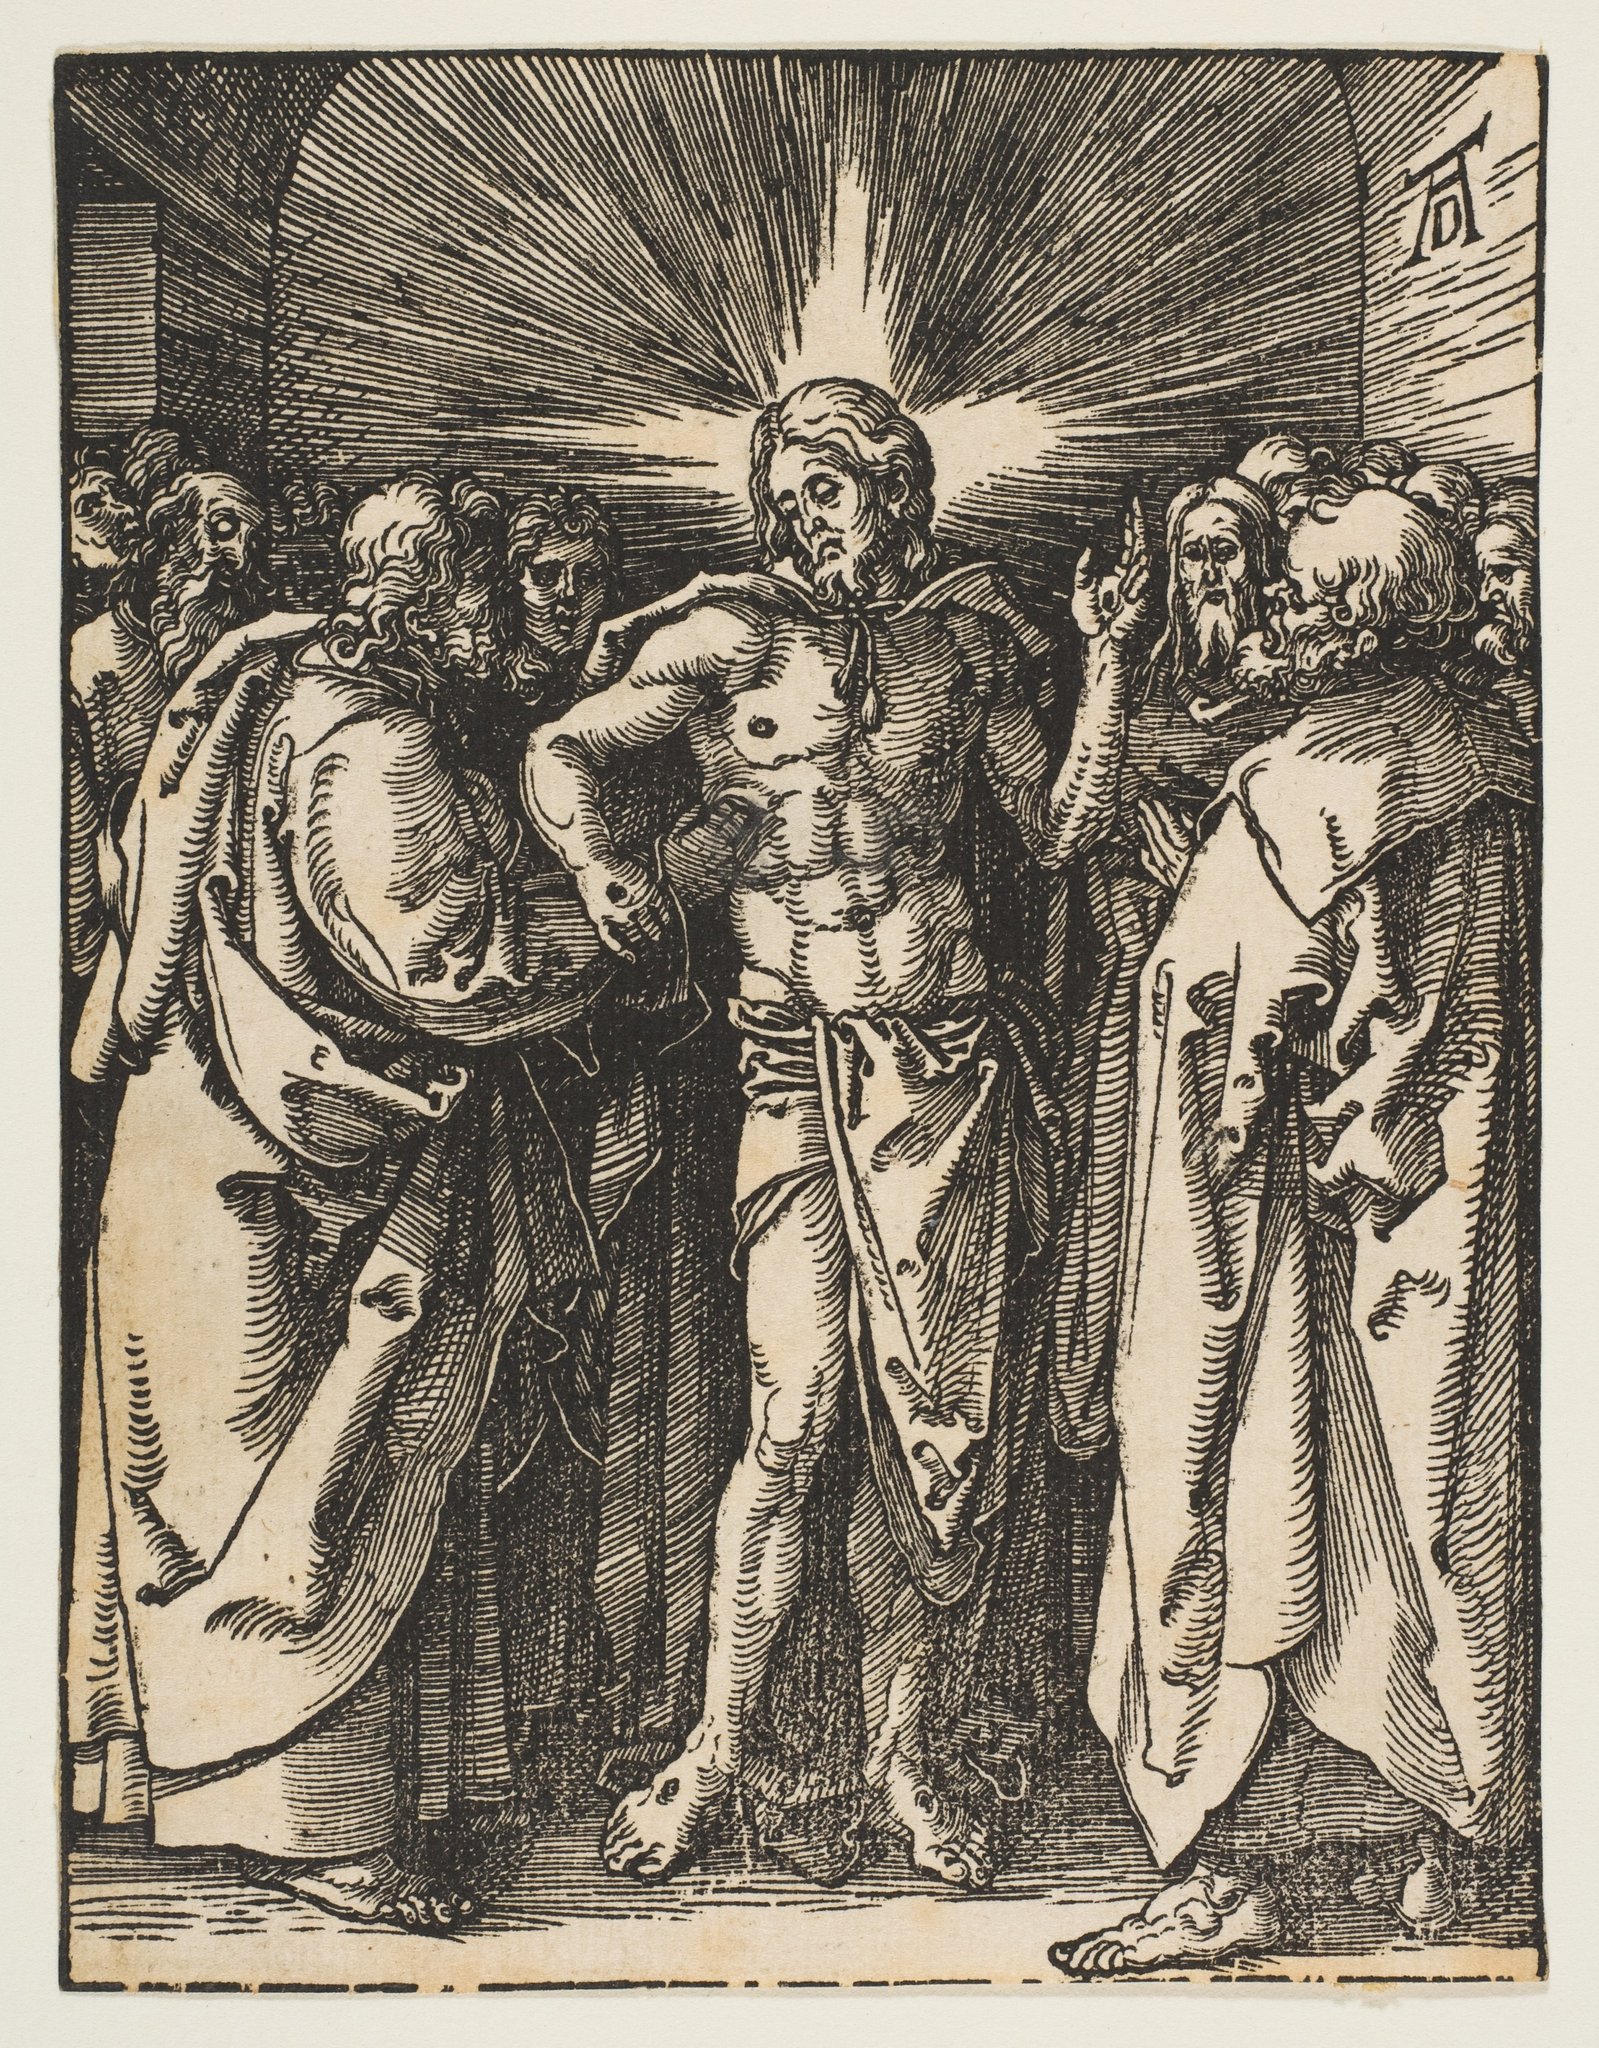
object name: print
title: The Doubting Thomas, from "The Small Passion"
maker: albrecht dürer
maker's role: artist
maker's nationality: german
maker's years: 1471-1528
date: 1510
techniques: woodcut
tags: men,christ